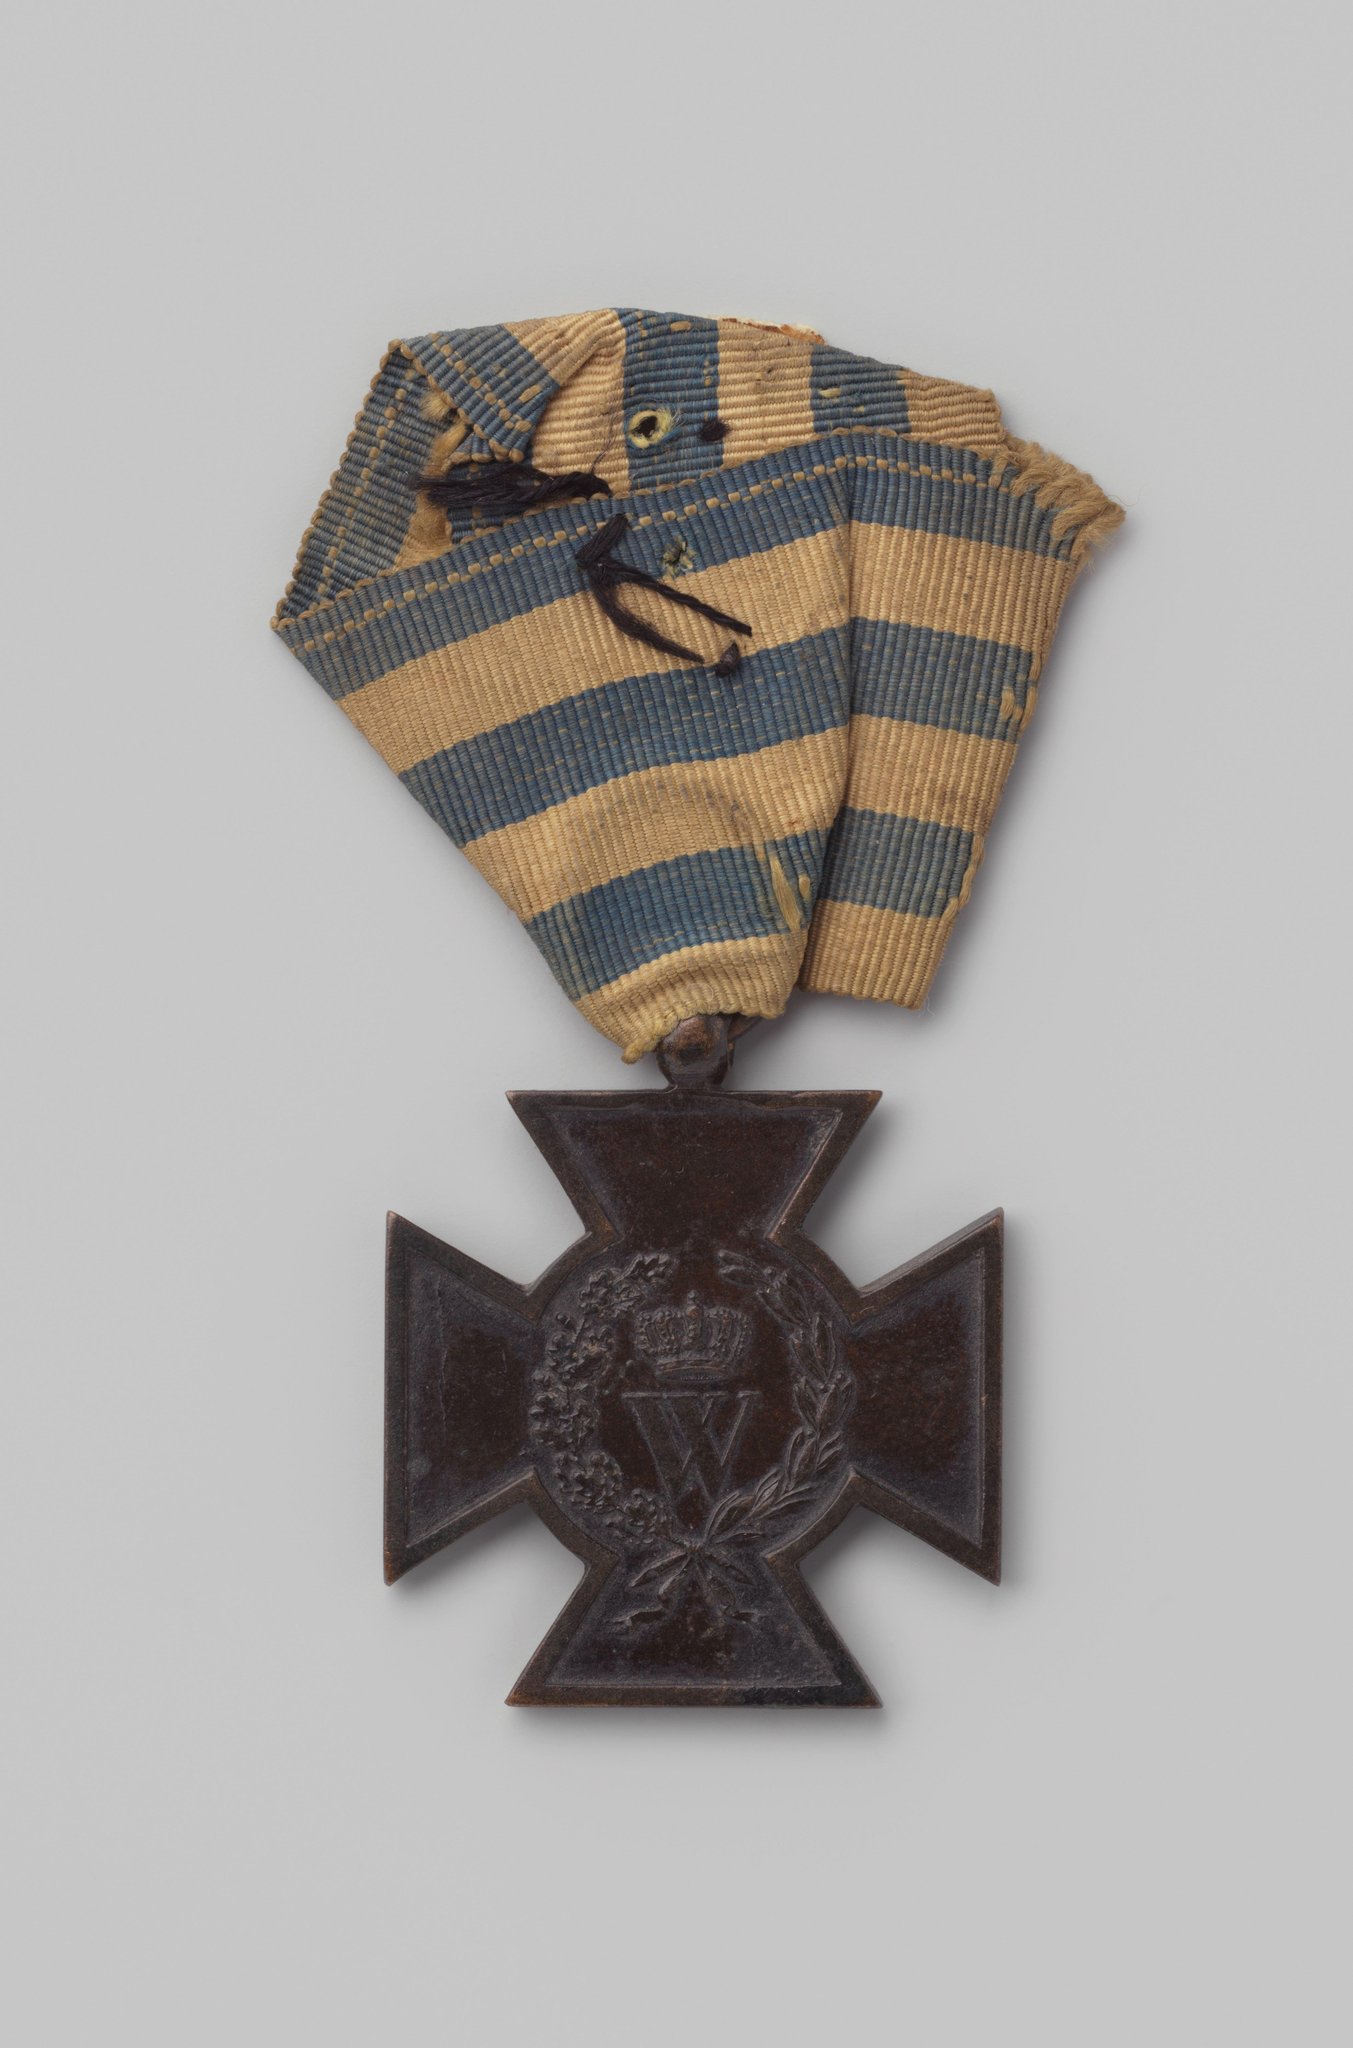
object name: onderscheidingsteken, onderscheiding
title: Metalen Kruis 1830-1831 met blauw-wit lint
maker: Anonymous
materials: bronze, textile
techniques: forging, striking, weave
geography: netherlands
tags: metalen kruis, belgische revolutie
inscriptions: : ‘TROUW AAN/ KONING/ EN/ VADERLAND’, : ‘gekroonde W’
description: Metalen kruis 1830-1831 met vier bronzen armen. Aan de voorzijde een gekroonde W omgeven door aan de linkerzijde eikenbladeren en aan de rechterzijde laurierbladeren welke elkaar onder de gekroonde W overlappen. Aan de achterzijde van het kruis een tekst op iedere arm, aan de bovenzijde TROUW AAN, rechterzijde KONING, onderzijde EN, en aan de linkerzijde VADERLAND. Centraal staat het jaartal 1830-1831. Aan de bovenzijde een ring waaraan het driemaal verticaal gestreepte blauw-wit lint bevestigd is. Het lint is dubbel gevouwen.